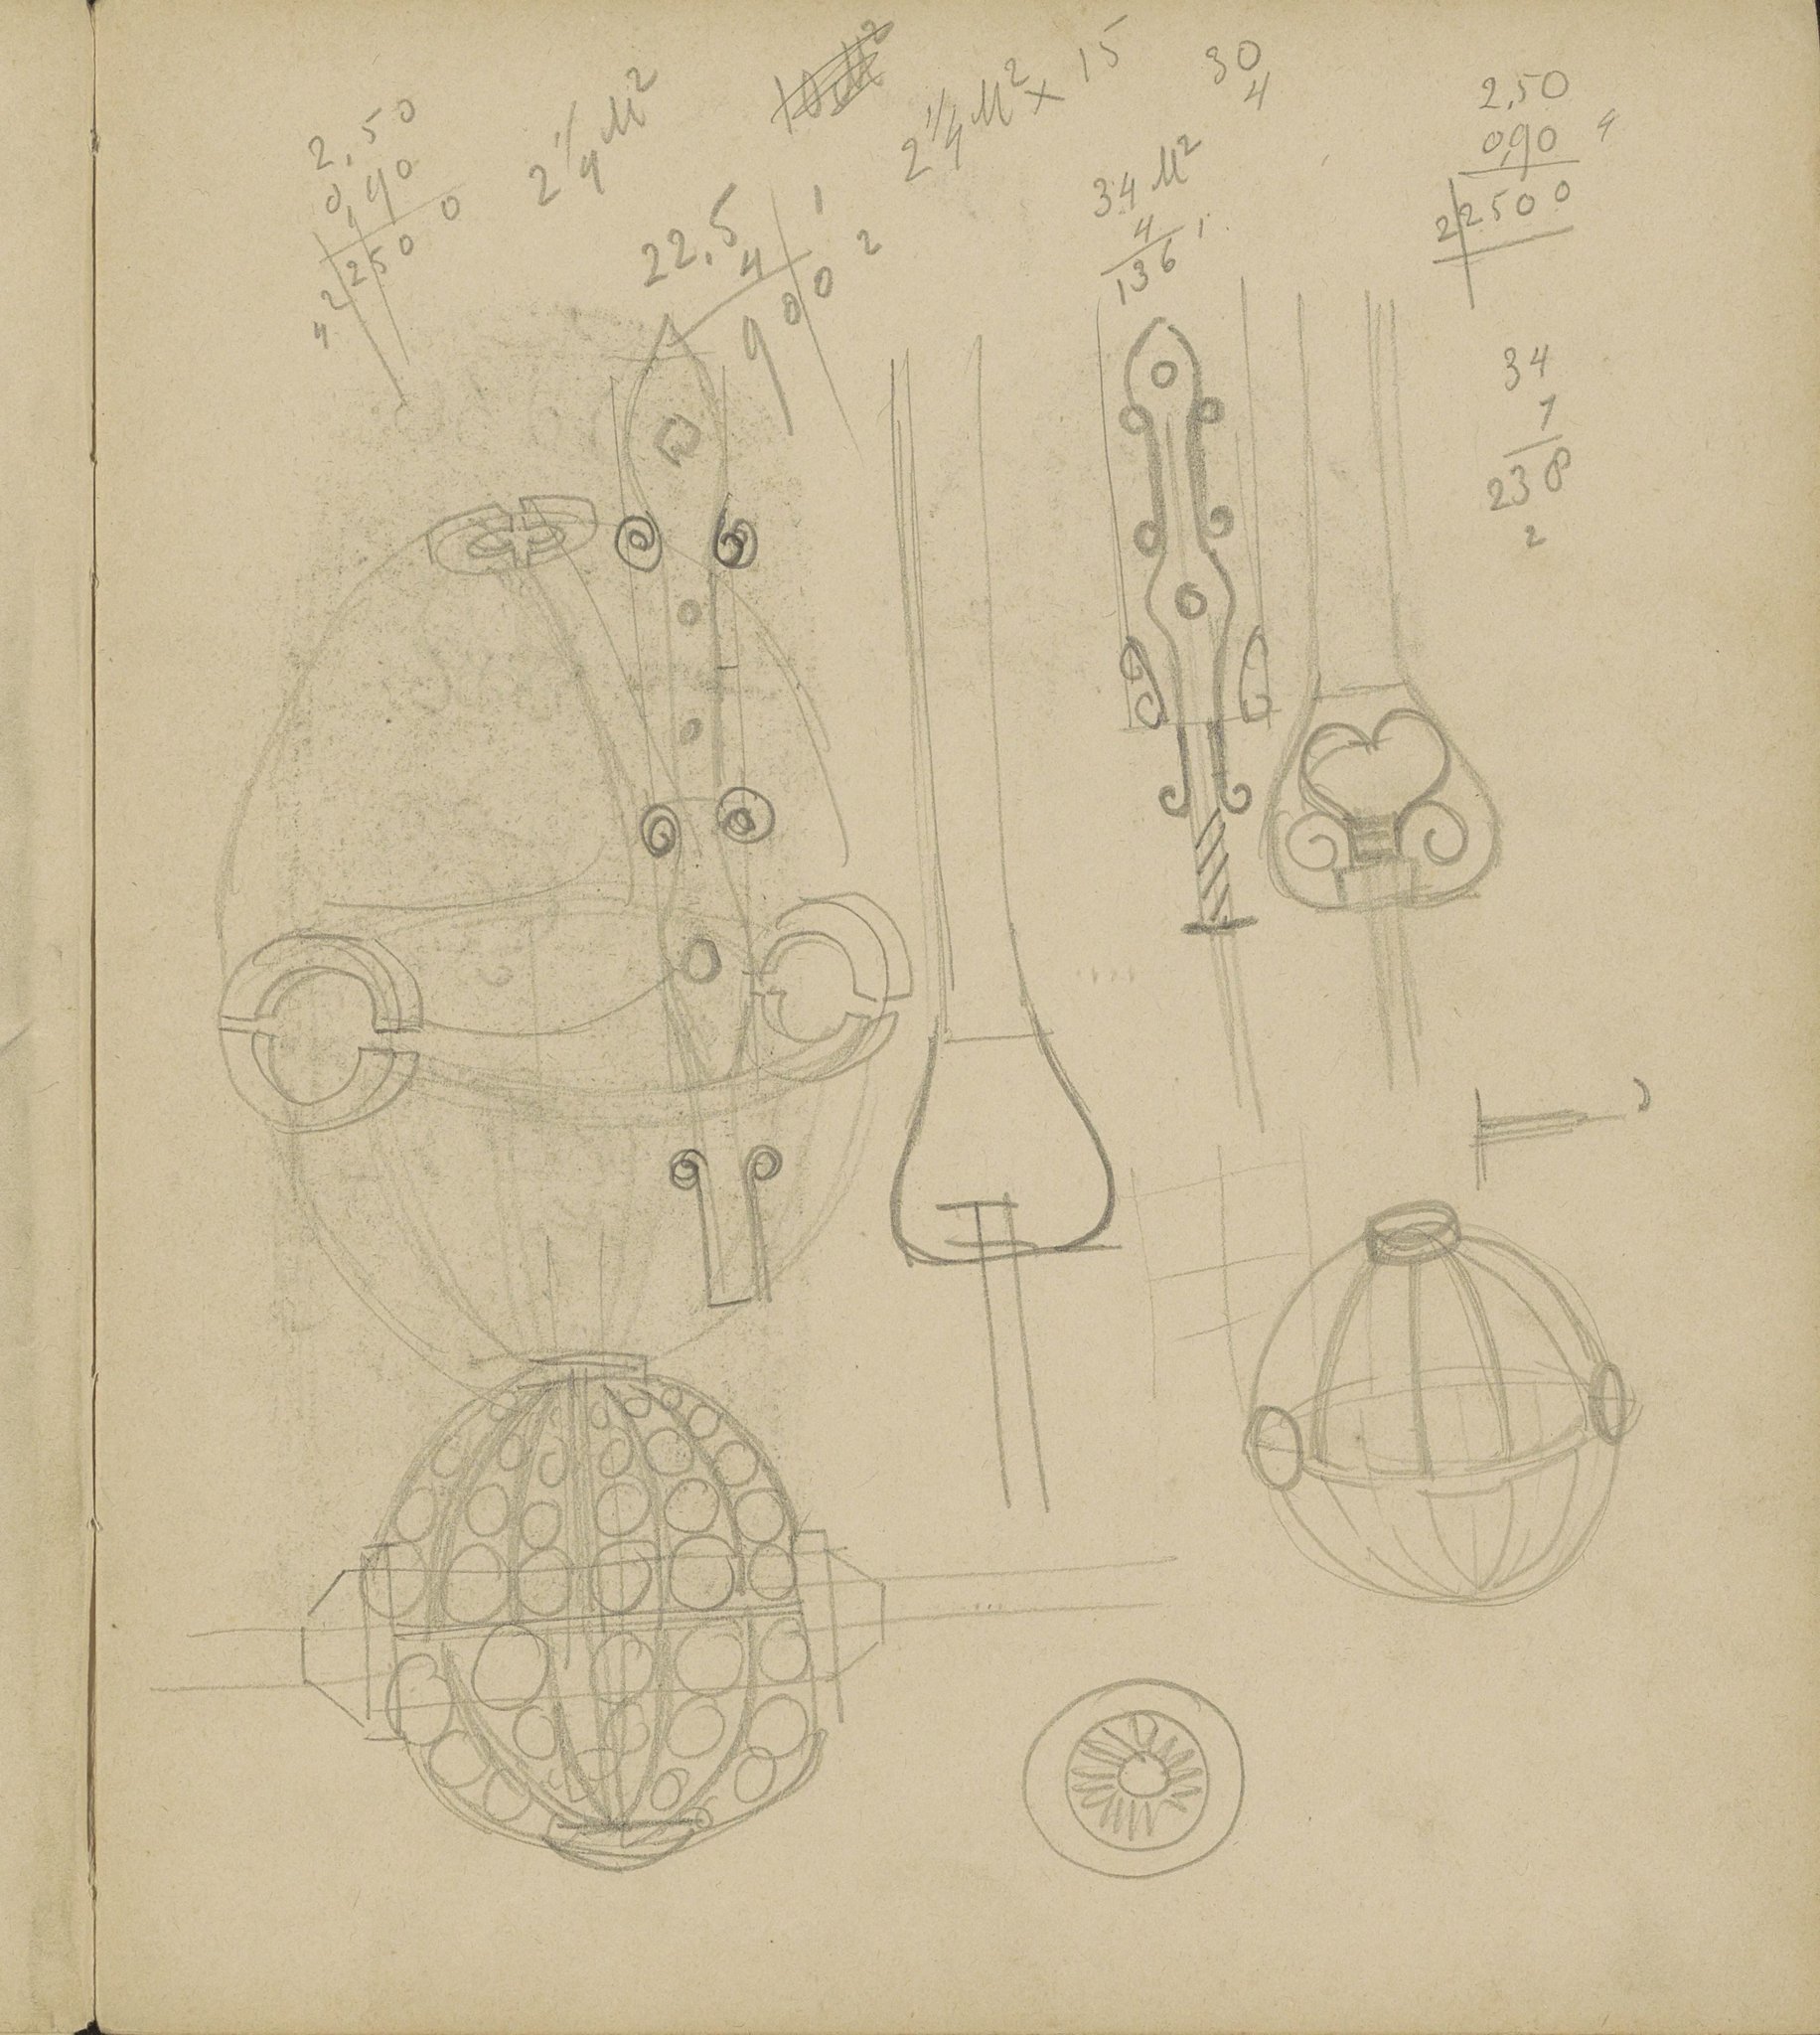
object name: sketchbook leaf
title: Ontwerpen voor lampen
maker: carel adolph lion cachet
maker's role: draughtsman, print maker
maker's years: 1864-1945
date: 1905-1906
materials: paper, pencil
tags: lighting; lamps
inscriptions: annotation: ‘[...]’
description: Blad 13 recto uit een schetsboek met 30 bladen.